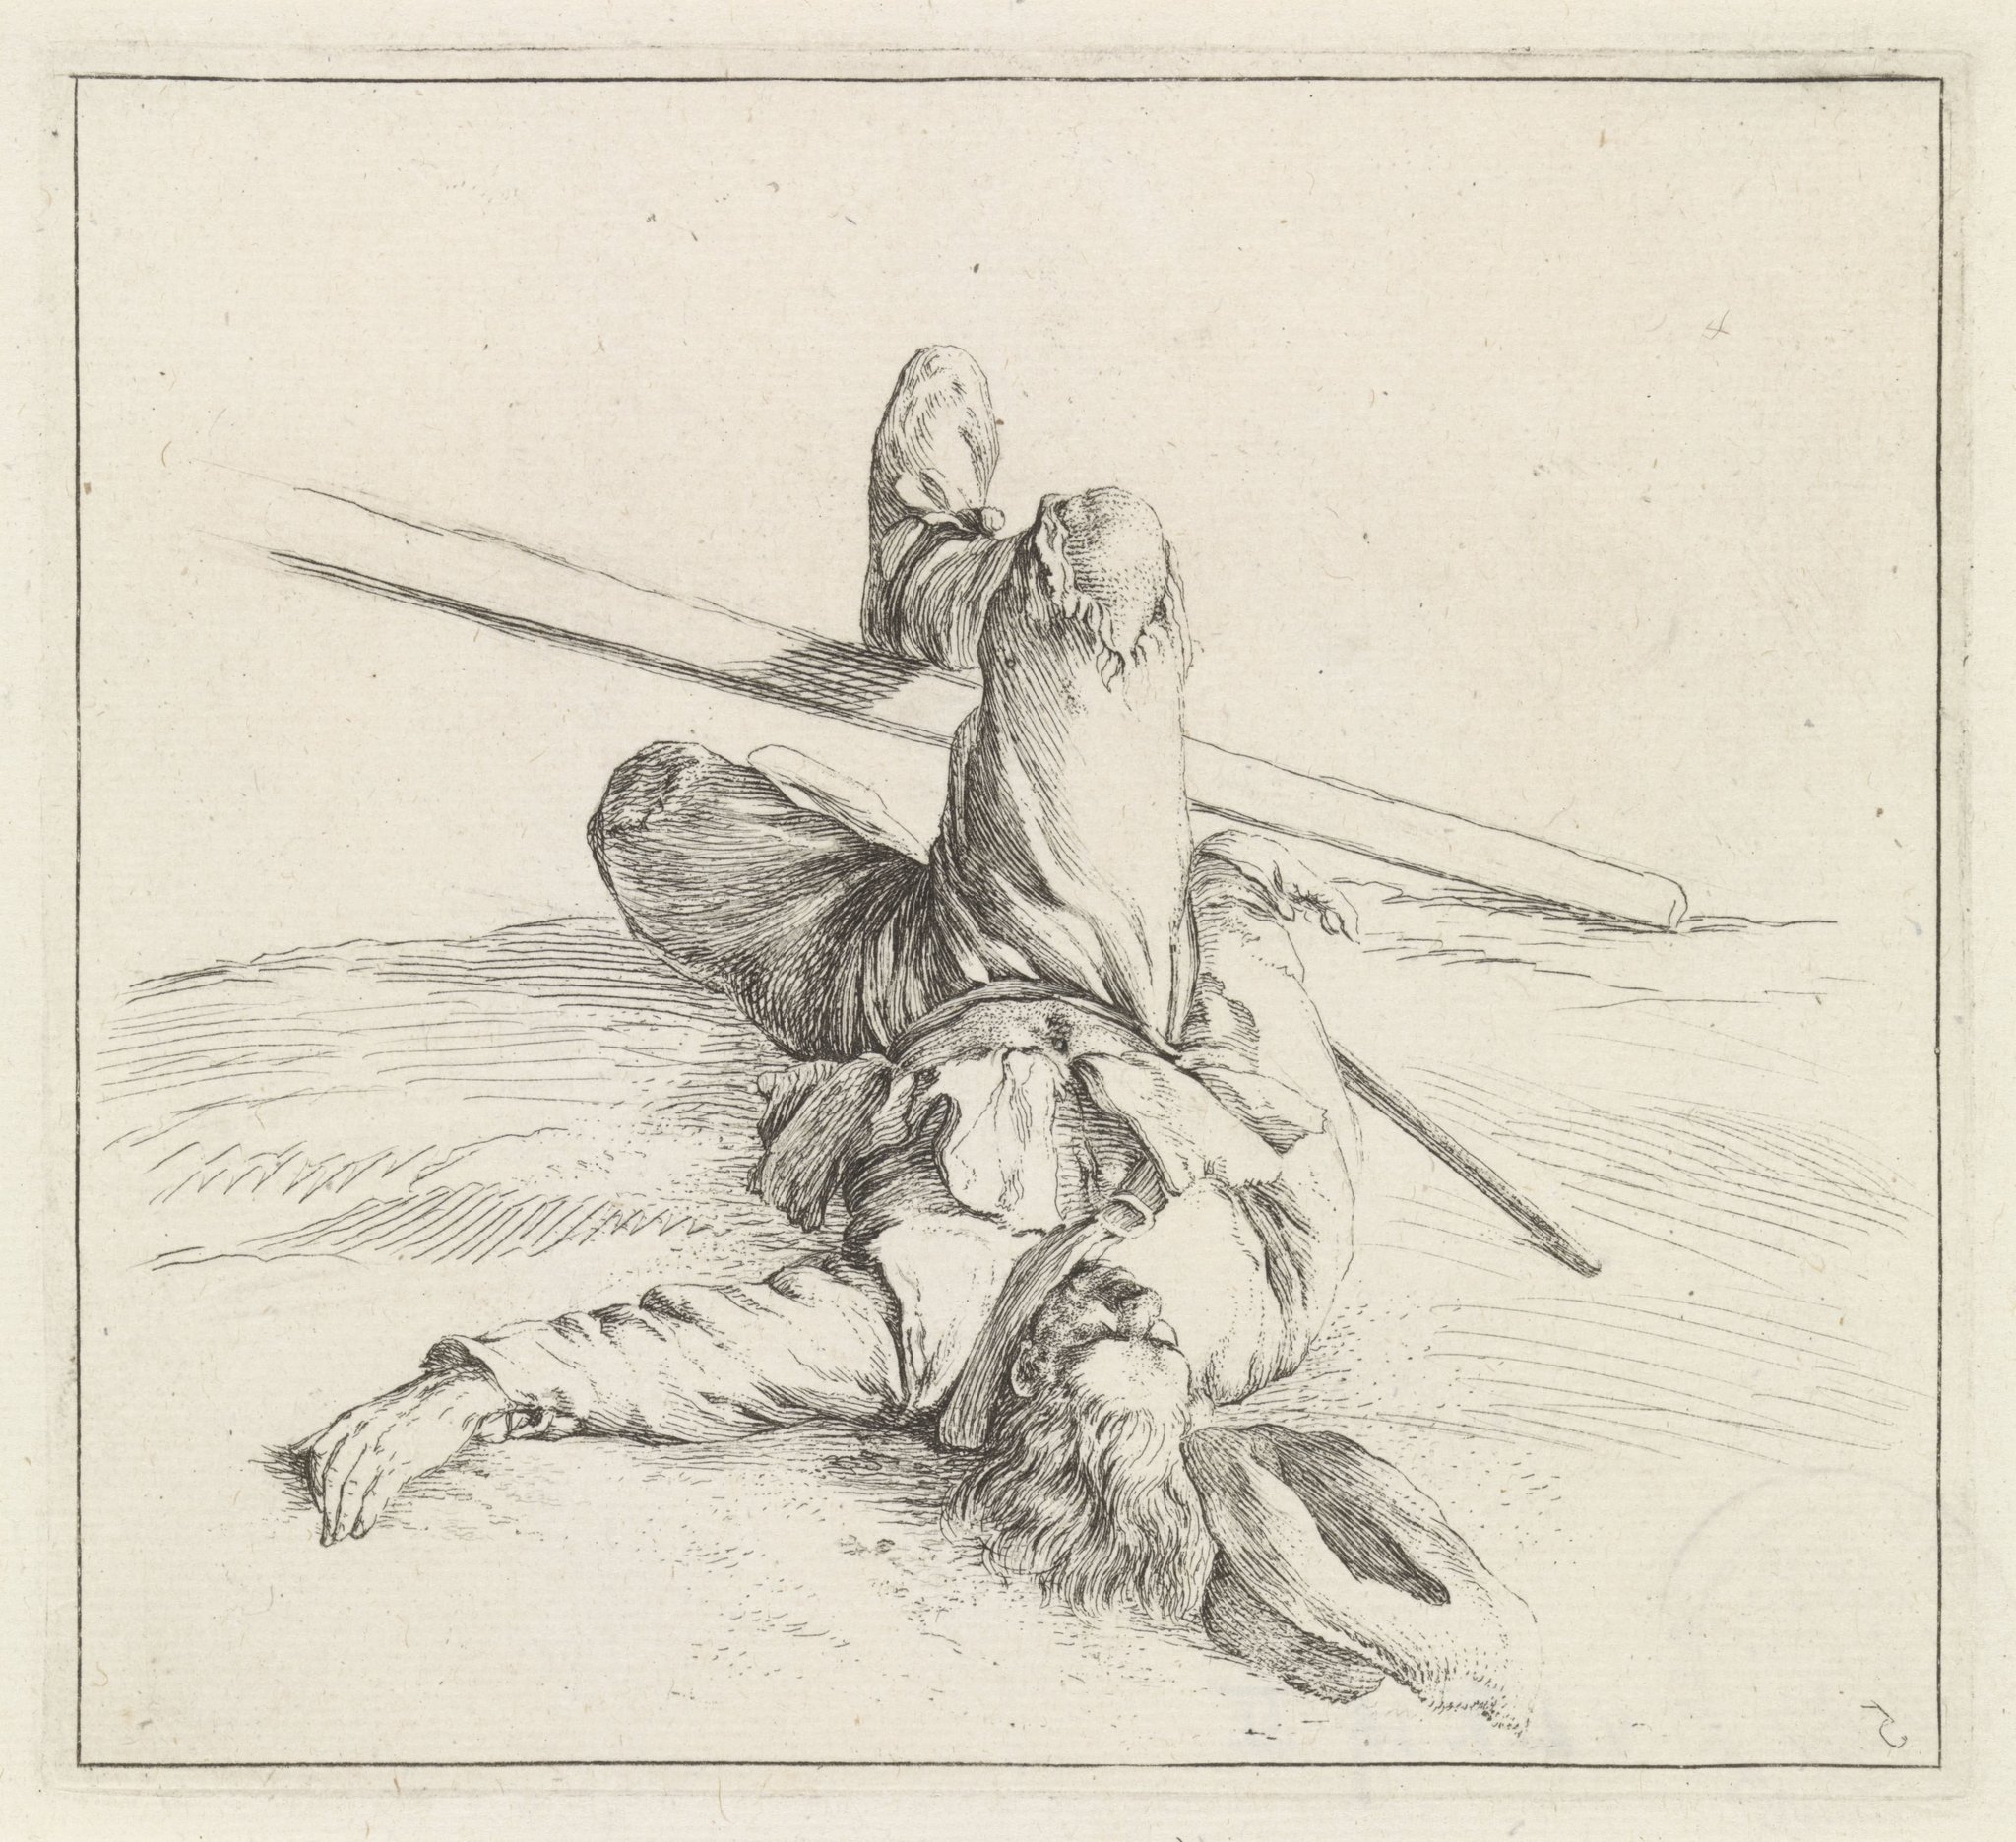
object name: print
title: Gewonde soldaat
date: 1710-1717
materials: paper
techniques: etching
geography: amsterdam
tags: the soldier; the soldier's life (+ weapons), putting out of action by wounding, lying figure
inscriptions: collector's mark: Lugt 240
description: Gewonde liggende soldaat. Vijfde prent uit een serie van twaalf prenten met voorstellingen van soldaten en paarden.